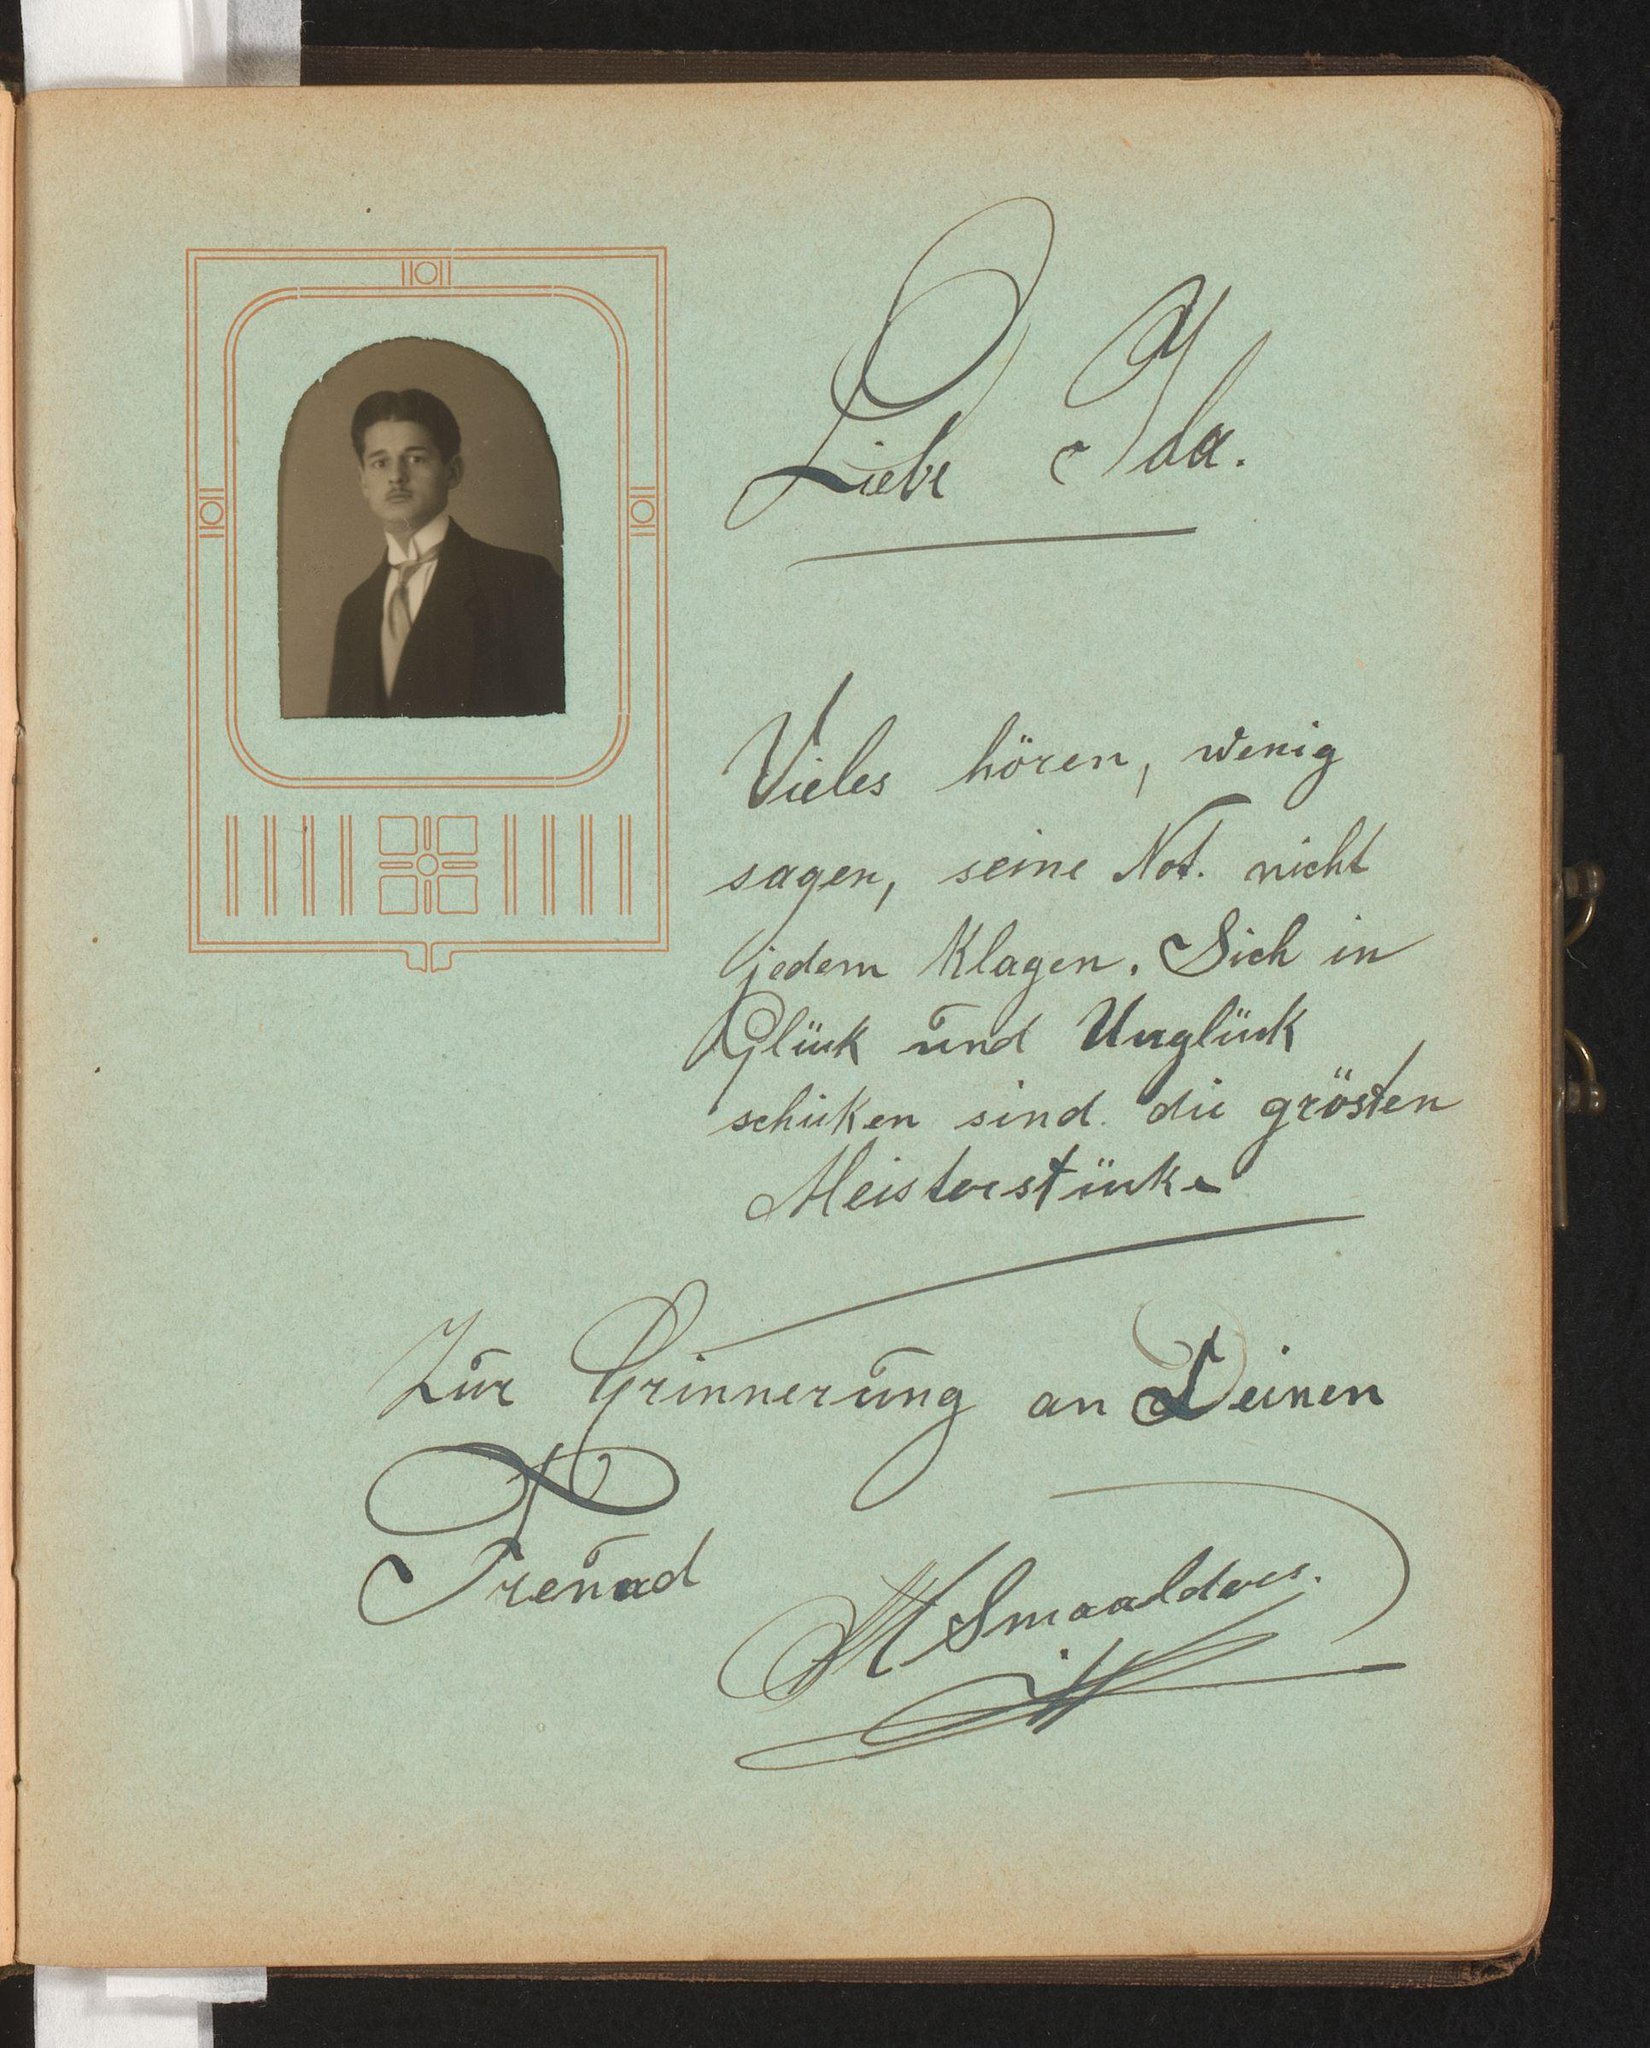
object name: snapshot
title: Portret van een jongeman met snor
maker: Anonymous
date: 1900-1930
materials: photographic support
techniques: gelatin silver print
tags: moustache, historical persons, youth, adolescent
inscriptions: annotation: ‘Liebe Ida/ (...)’